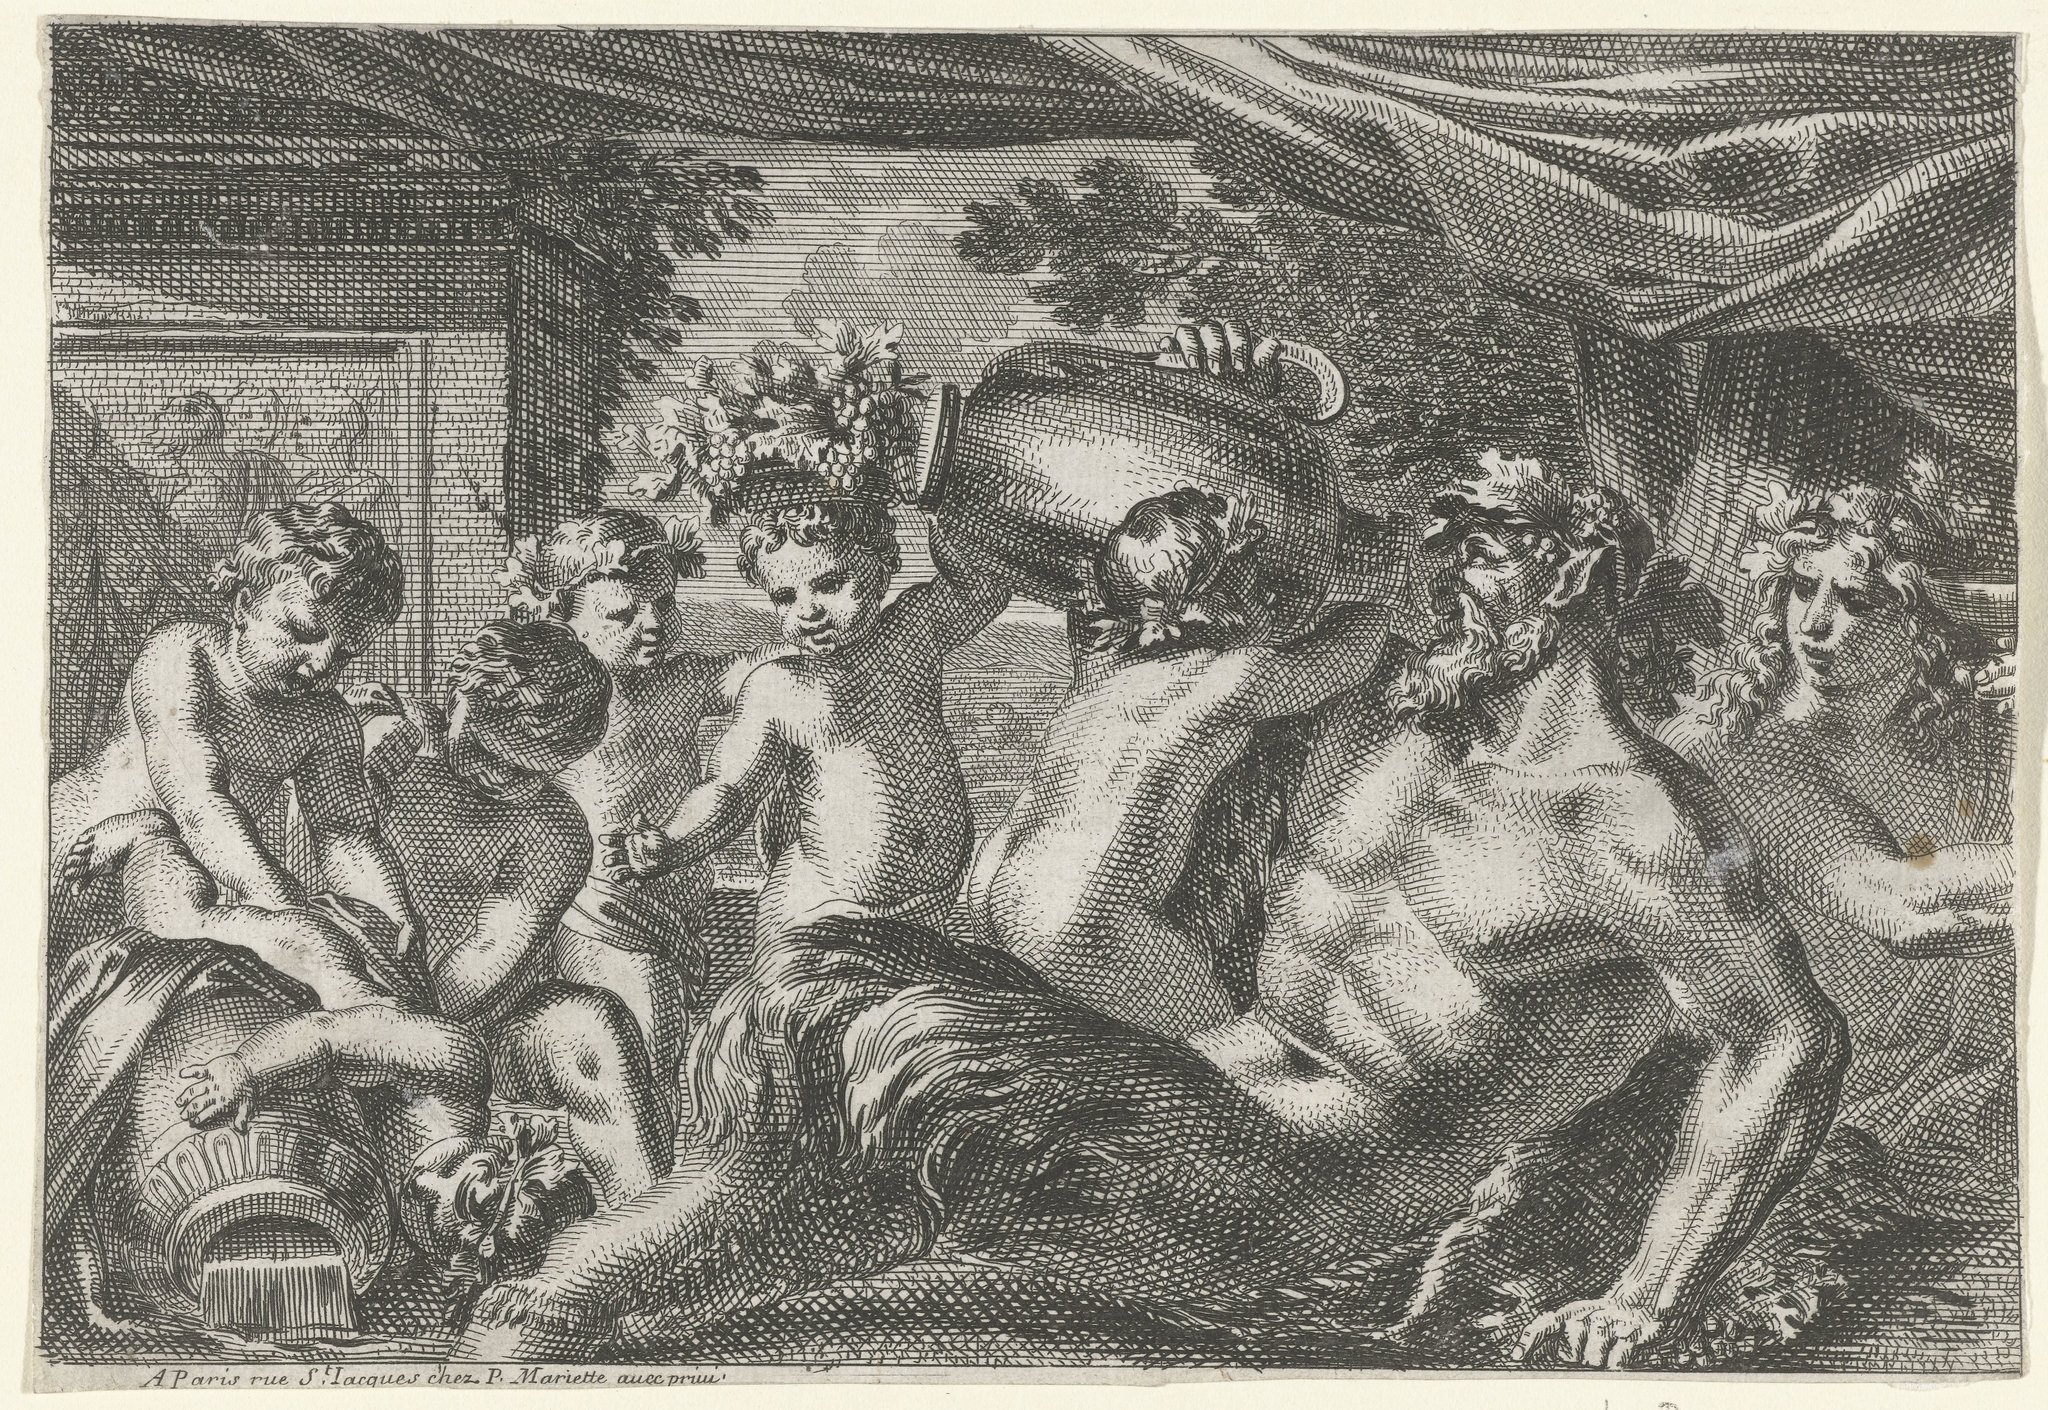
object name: ornament print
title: Bacchant, sater en kinderen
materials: paper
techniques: etching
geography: france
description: De bacchant en de sater drinken uit een kan die door kinderen omhoog wordt gehouden. Blad uit serie van 6 bladen.